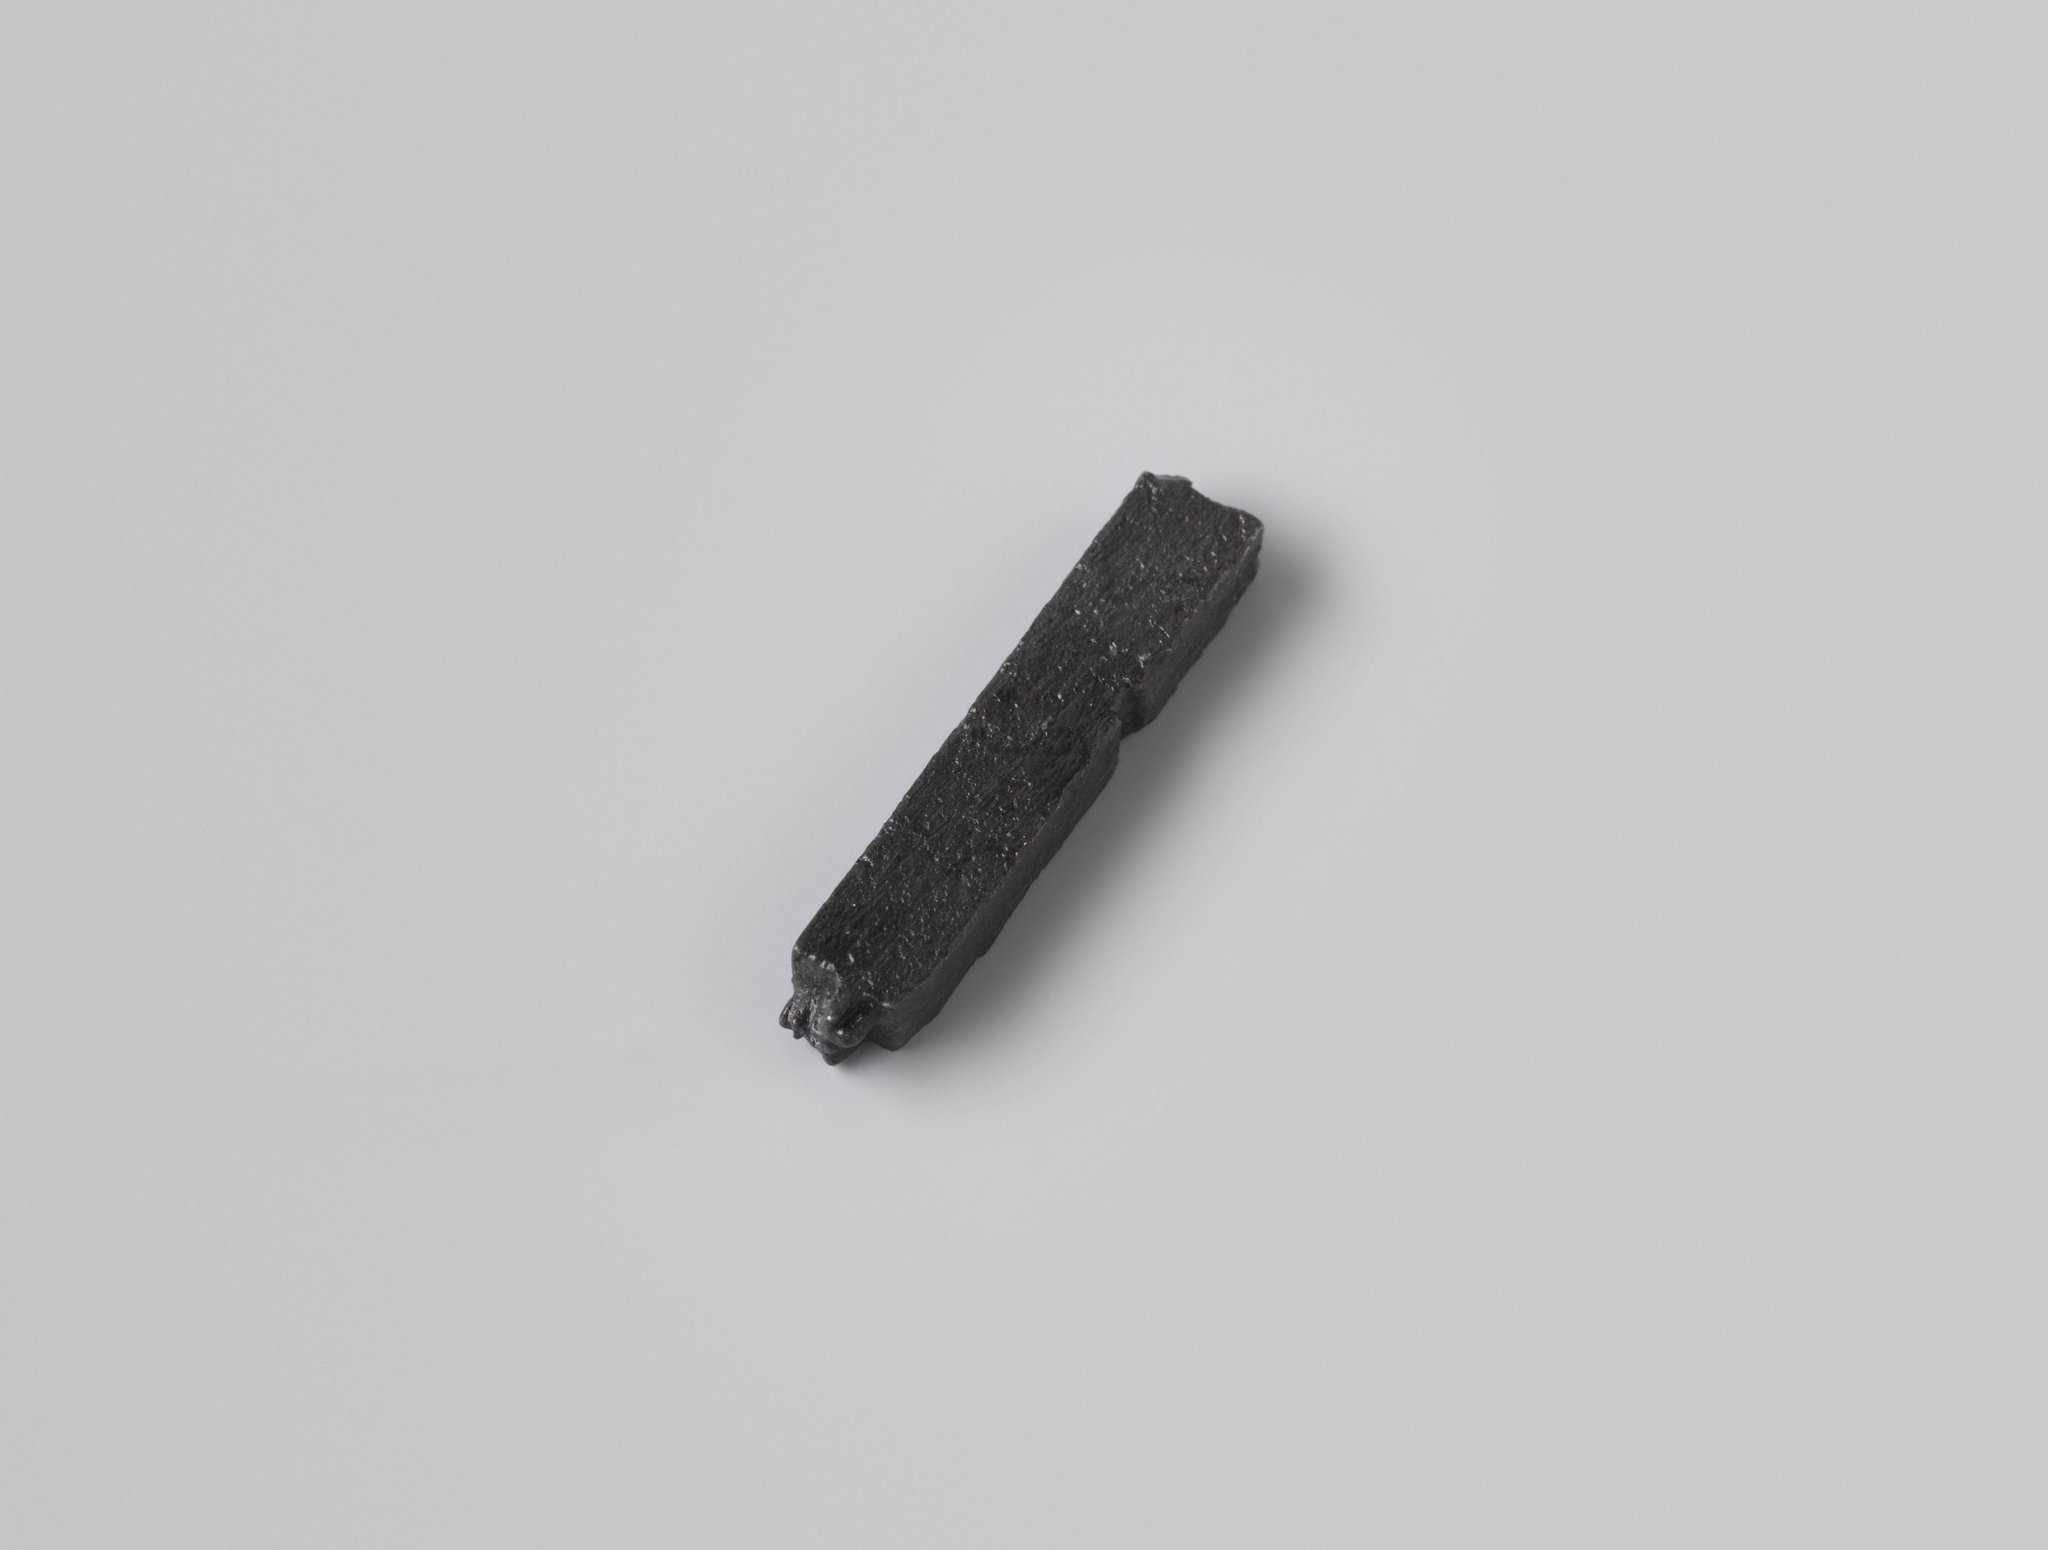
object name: type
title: Printing type with the Malay character syin from the wreck of the Dutch East India ship Hollandia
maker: Anonymous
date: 1700-1743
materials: lead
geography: netherlands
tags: verenigde oostindische compagnie, hollandia (schip), annet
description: Printing type; rectangular, groove in one side, 1 character [Malay letter syin], concave underneath.